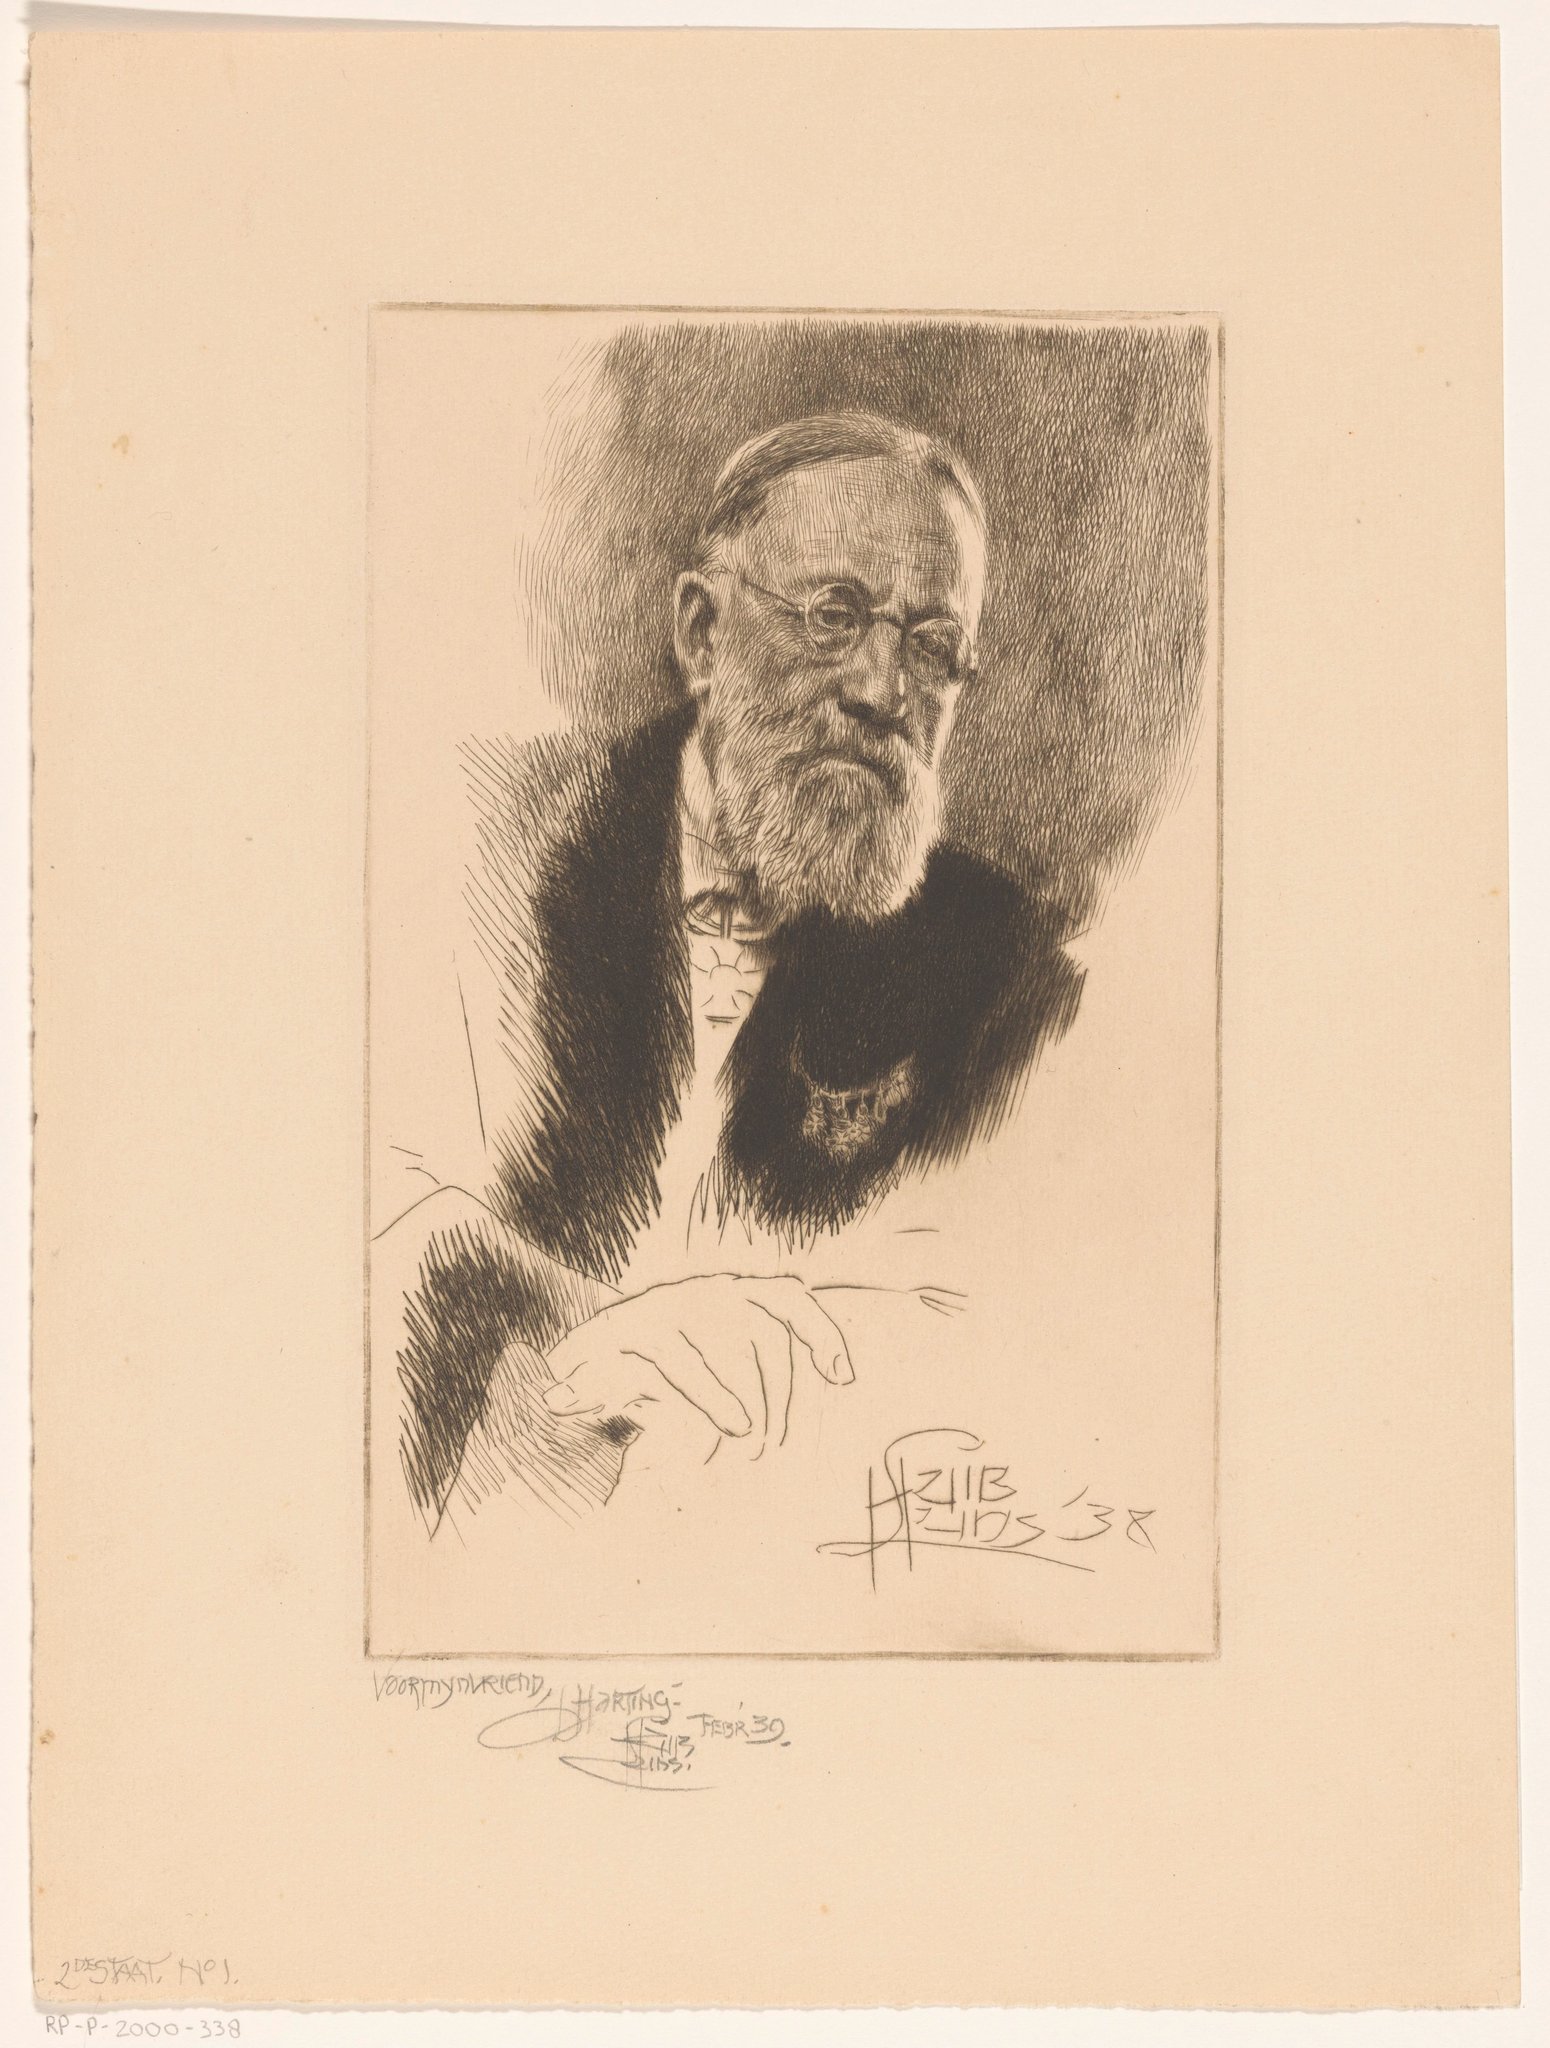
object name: print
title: Zelfportret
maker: huib luns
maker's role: draughtsman, print maker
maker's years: 1881-1942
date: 1938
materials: paper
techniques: etching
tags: paris, amsterdam, print maker, draughtsman, huib luns, portrait, self-portrait of artist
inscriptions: dedication: ‘Voor mijn vriend D. Harting. Febr. '39. Huib Luns.’, collector's mark: Lugt 2760, collector's mark: Lugt 2228